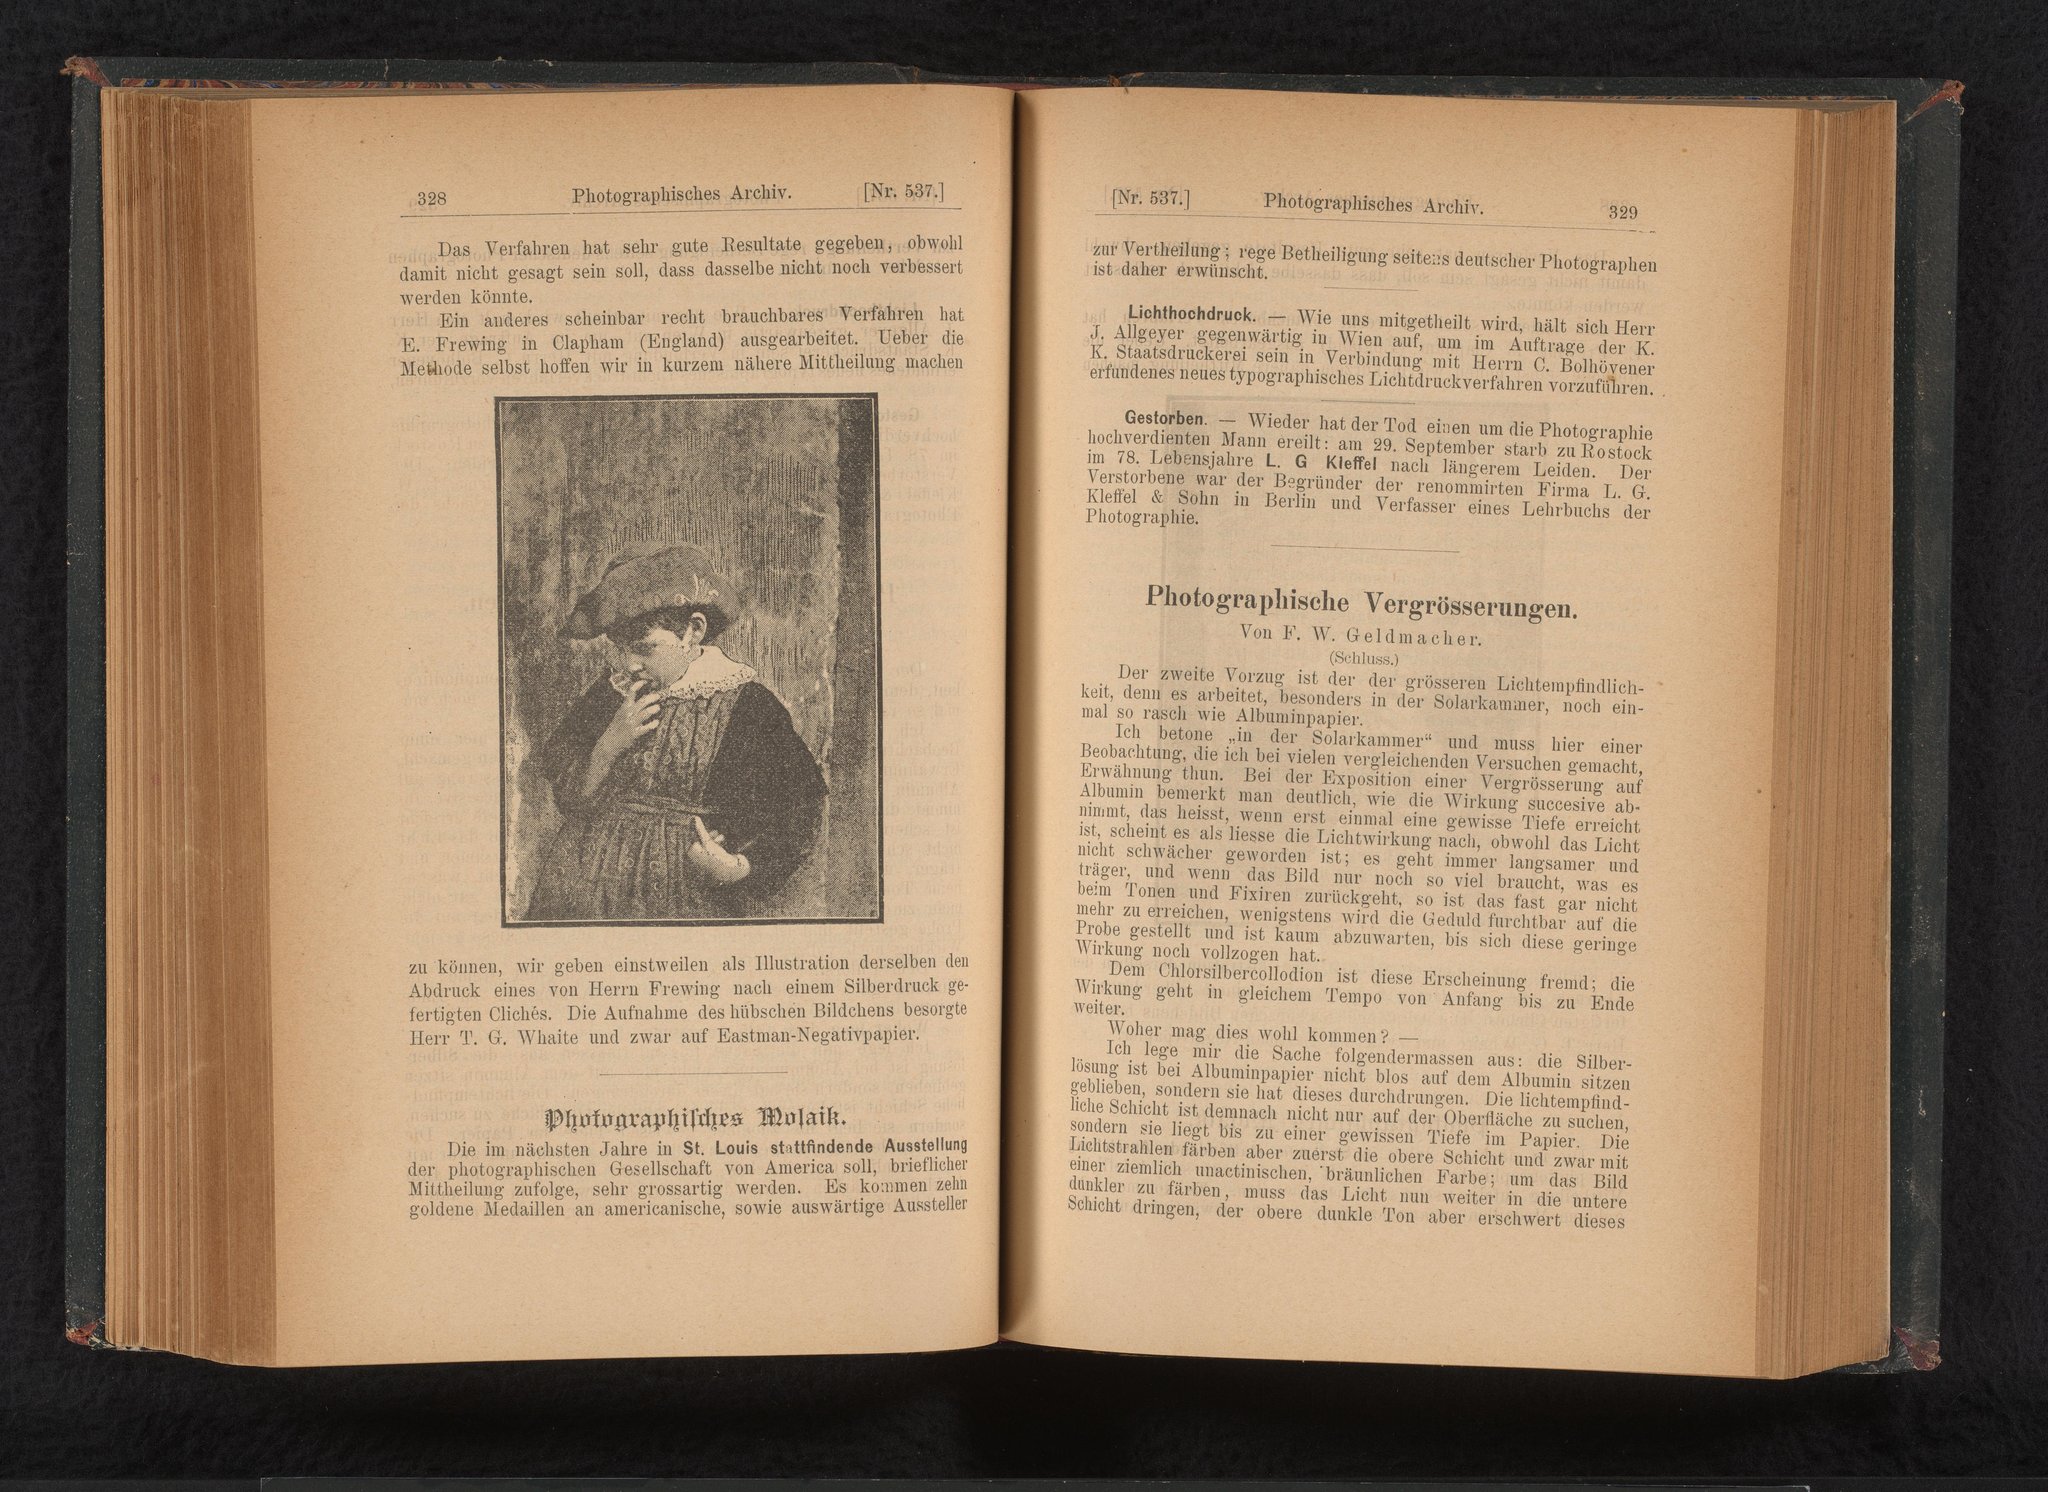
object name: page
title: Portret van een onbekende jongen met een hoed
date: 1880-1885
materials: paper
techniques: autotype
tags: boy (child between toddler and youth), historical persons not known by name